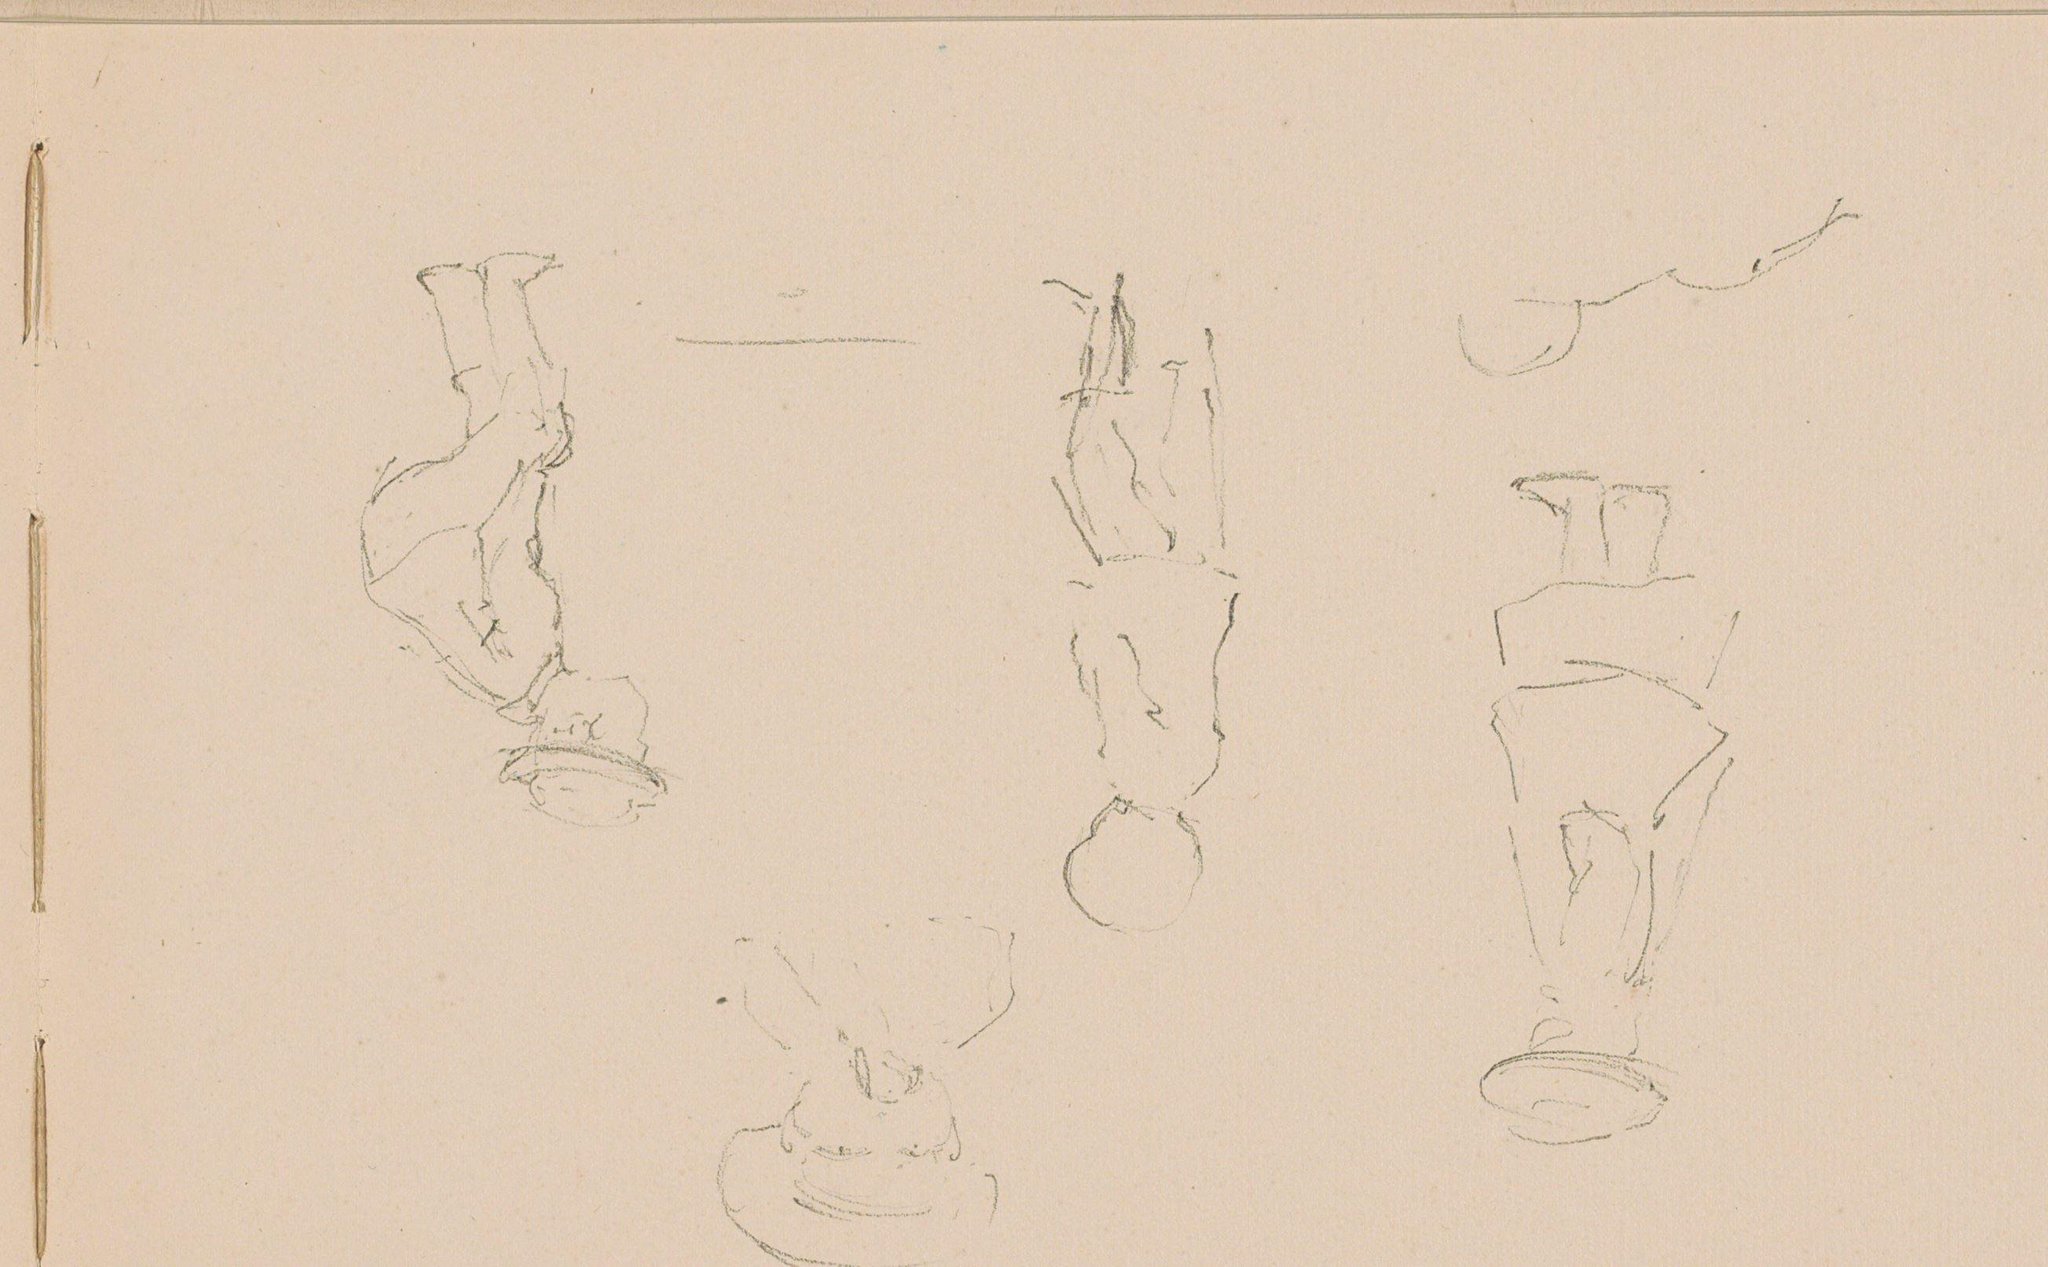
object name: sketchbook leaf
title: Spelende jongens en meisjes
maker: a.a.l. de grammont-hubrecht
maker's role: draughtsman, painter, print maker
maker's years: 1855-1913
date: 1865-1913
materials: chalk, paper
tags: children's games and plays, boy (child between toddler and youth), girl (child between toddler and youth)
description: De kinderen zijn in verschillende houdingen getekend: bukkend, staand en blazend op een rietje. Blad 21 recto uit een schetsboek met 28 bladen.